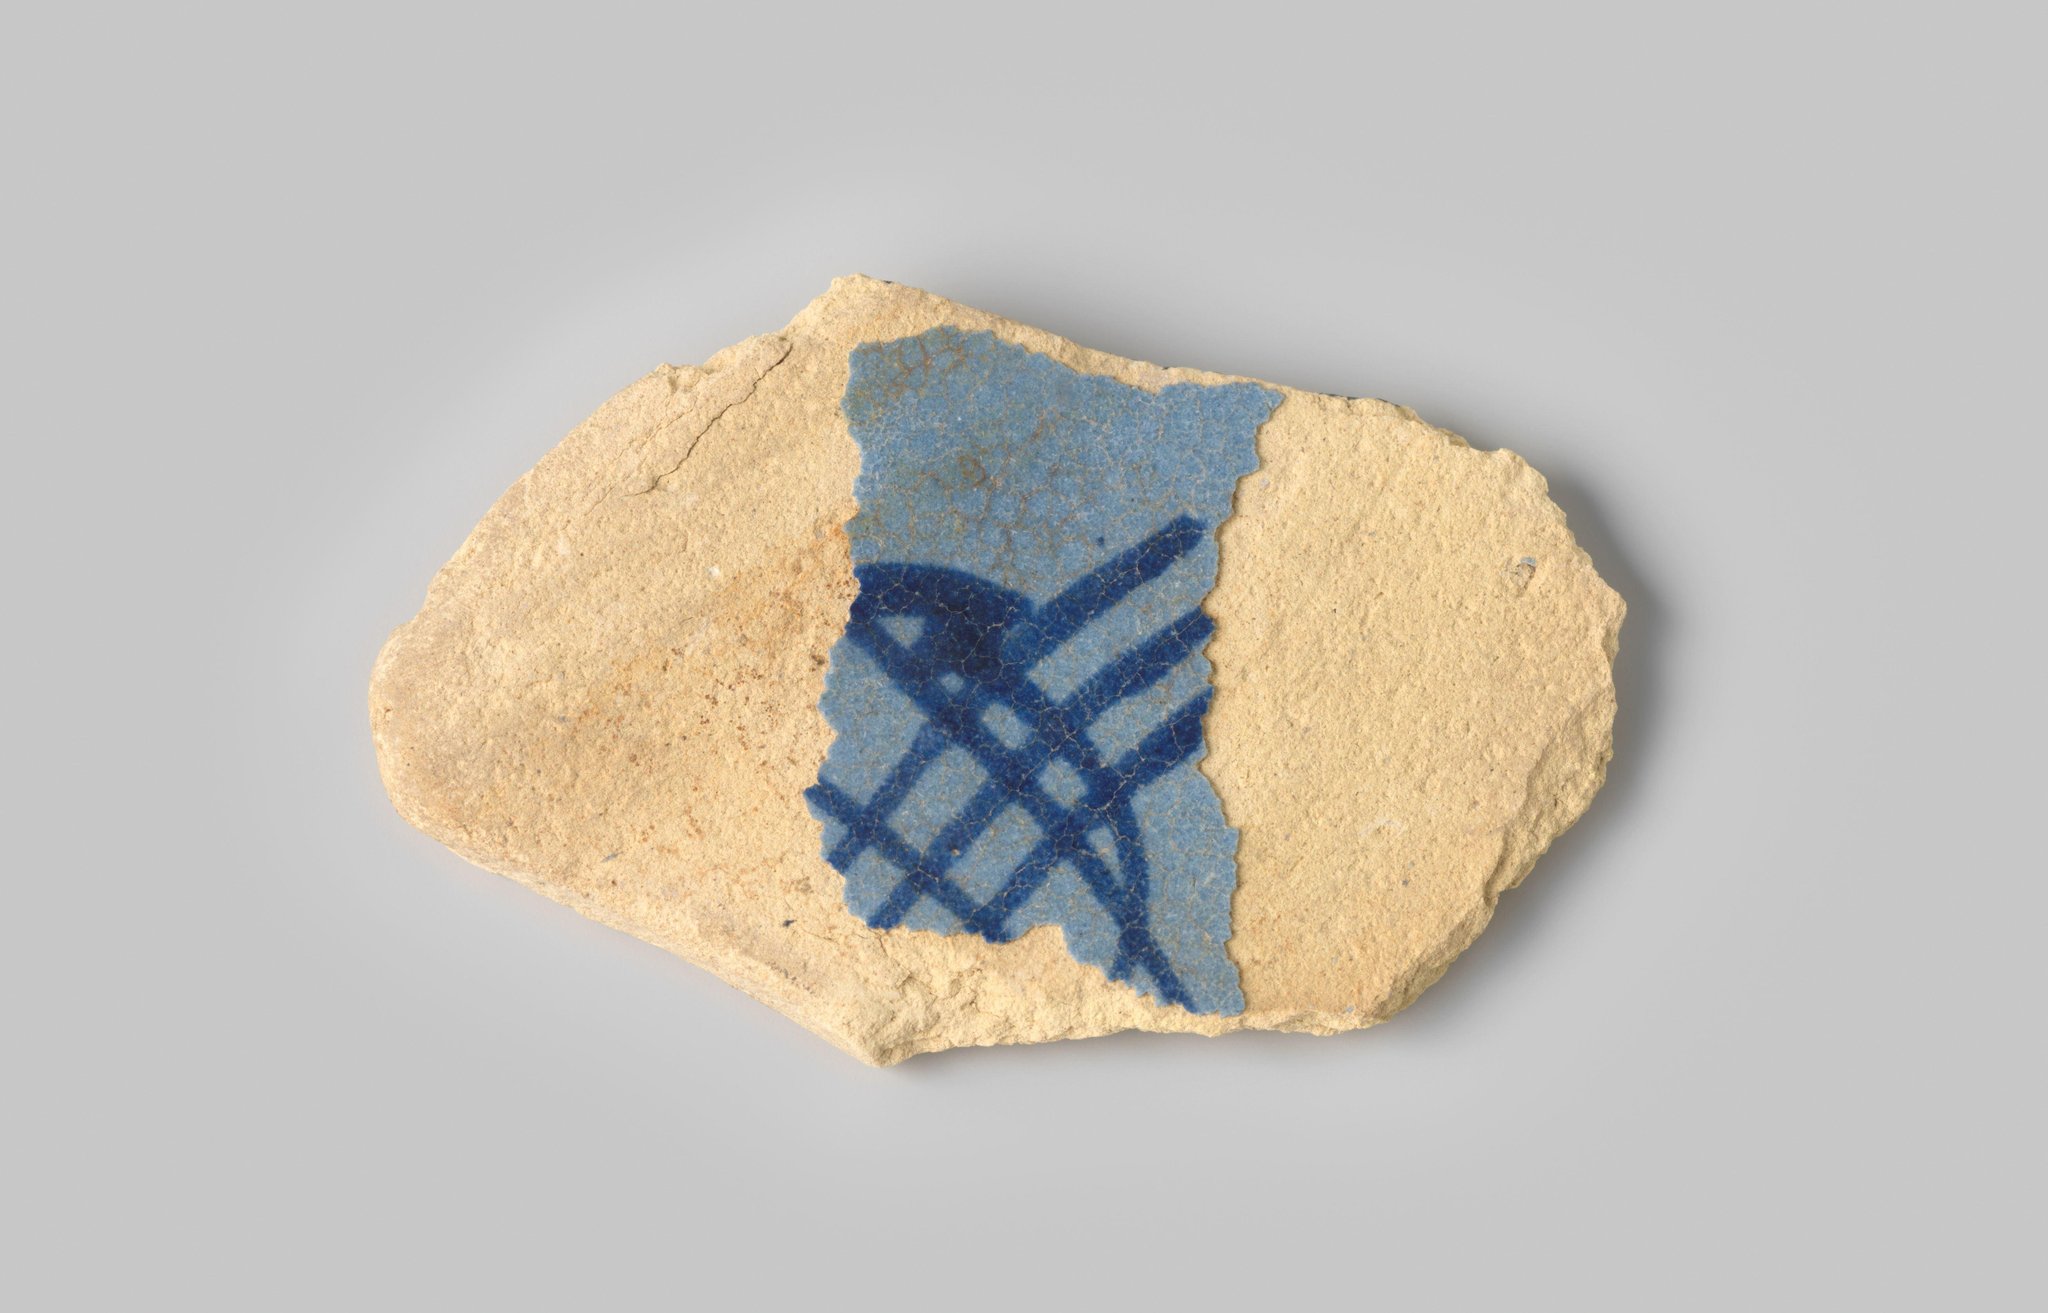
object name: sherd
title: Fragment van een schotel met geelbakkende scherf, met aan de voor- en achterzijde resten van lichtblauw glazuur, beschilderd met donkerblauw glazuur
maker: Anonymous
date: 1200-1899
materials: earthenware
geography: italy